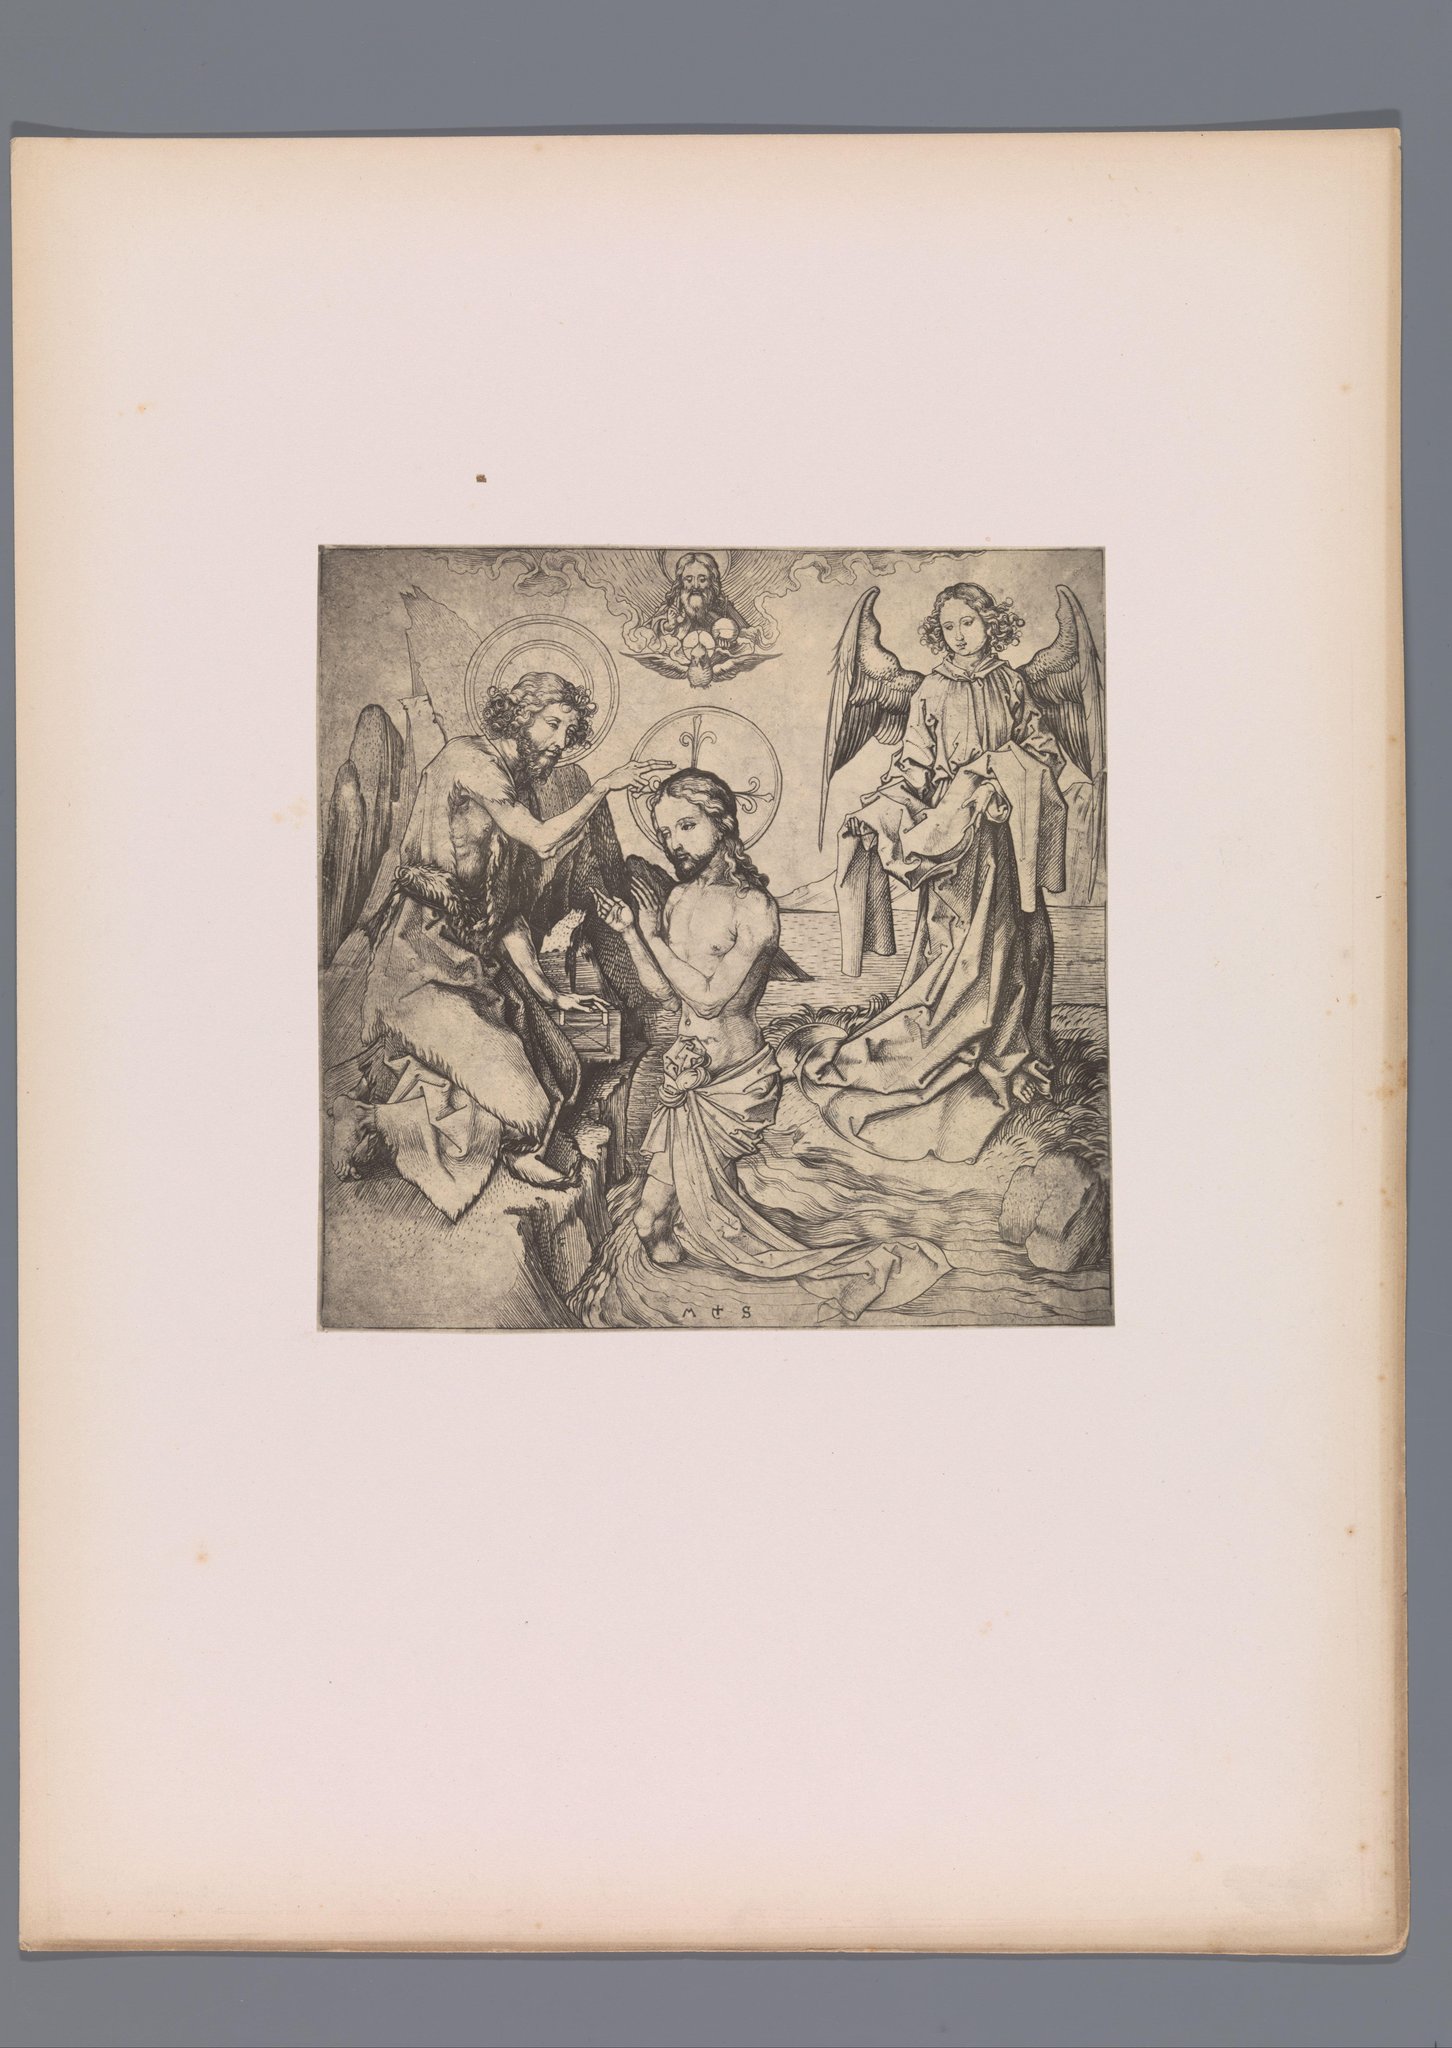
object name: reproduction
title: Reproductie van een prent van de doop van Christus door Martin Schongauer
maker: martin schongauer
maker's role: print maker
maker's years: 1430-1491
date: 1867-1872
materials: paper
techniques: woodburytype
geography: brussels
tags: baptism of christ in the river jordan: john the baptist pouring out water on christ's head: the holy ghost descends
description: Deze prent maakt deel uit van een omslag met 24 prenten op 24 bladen.